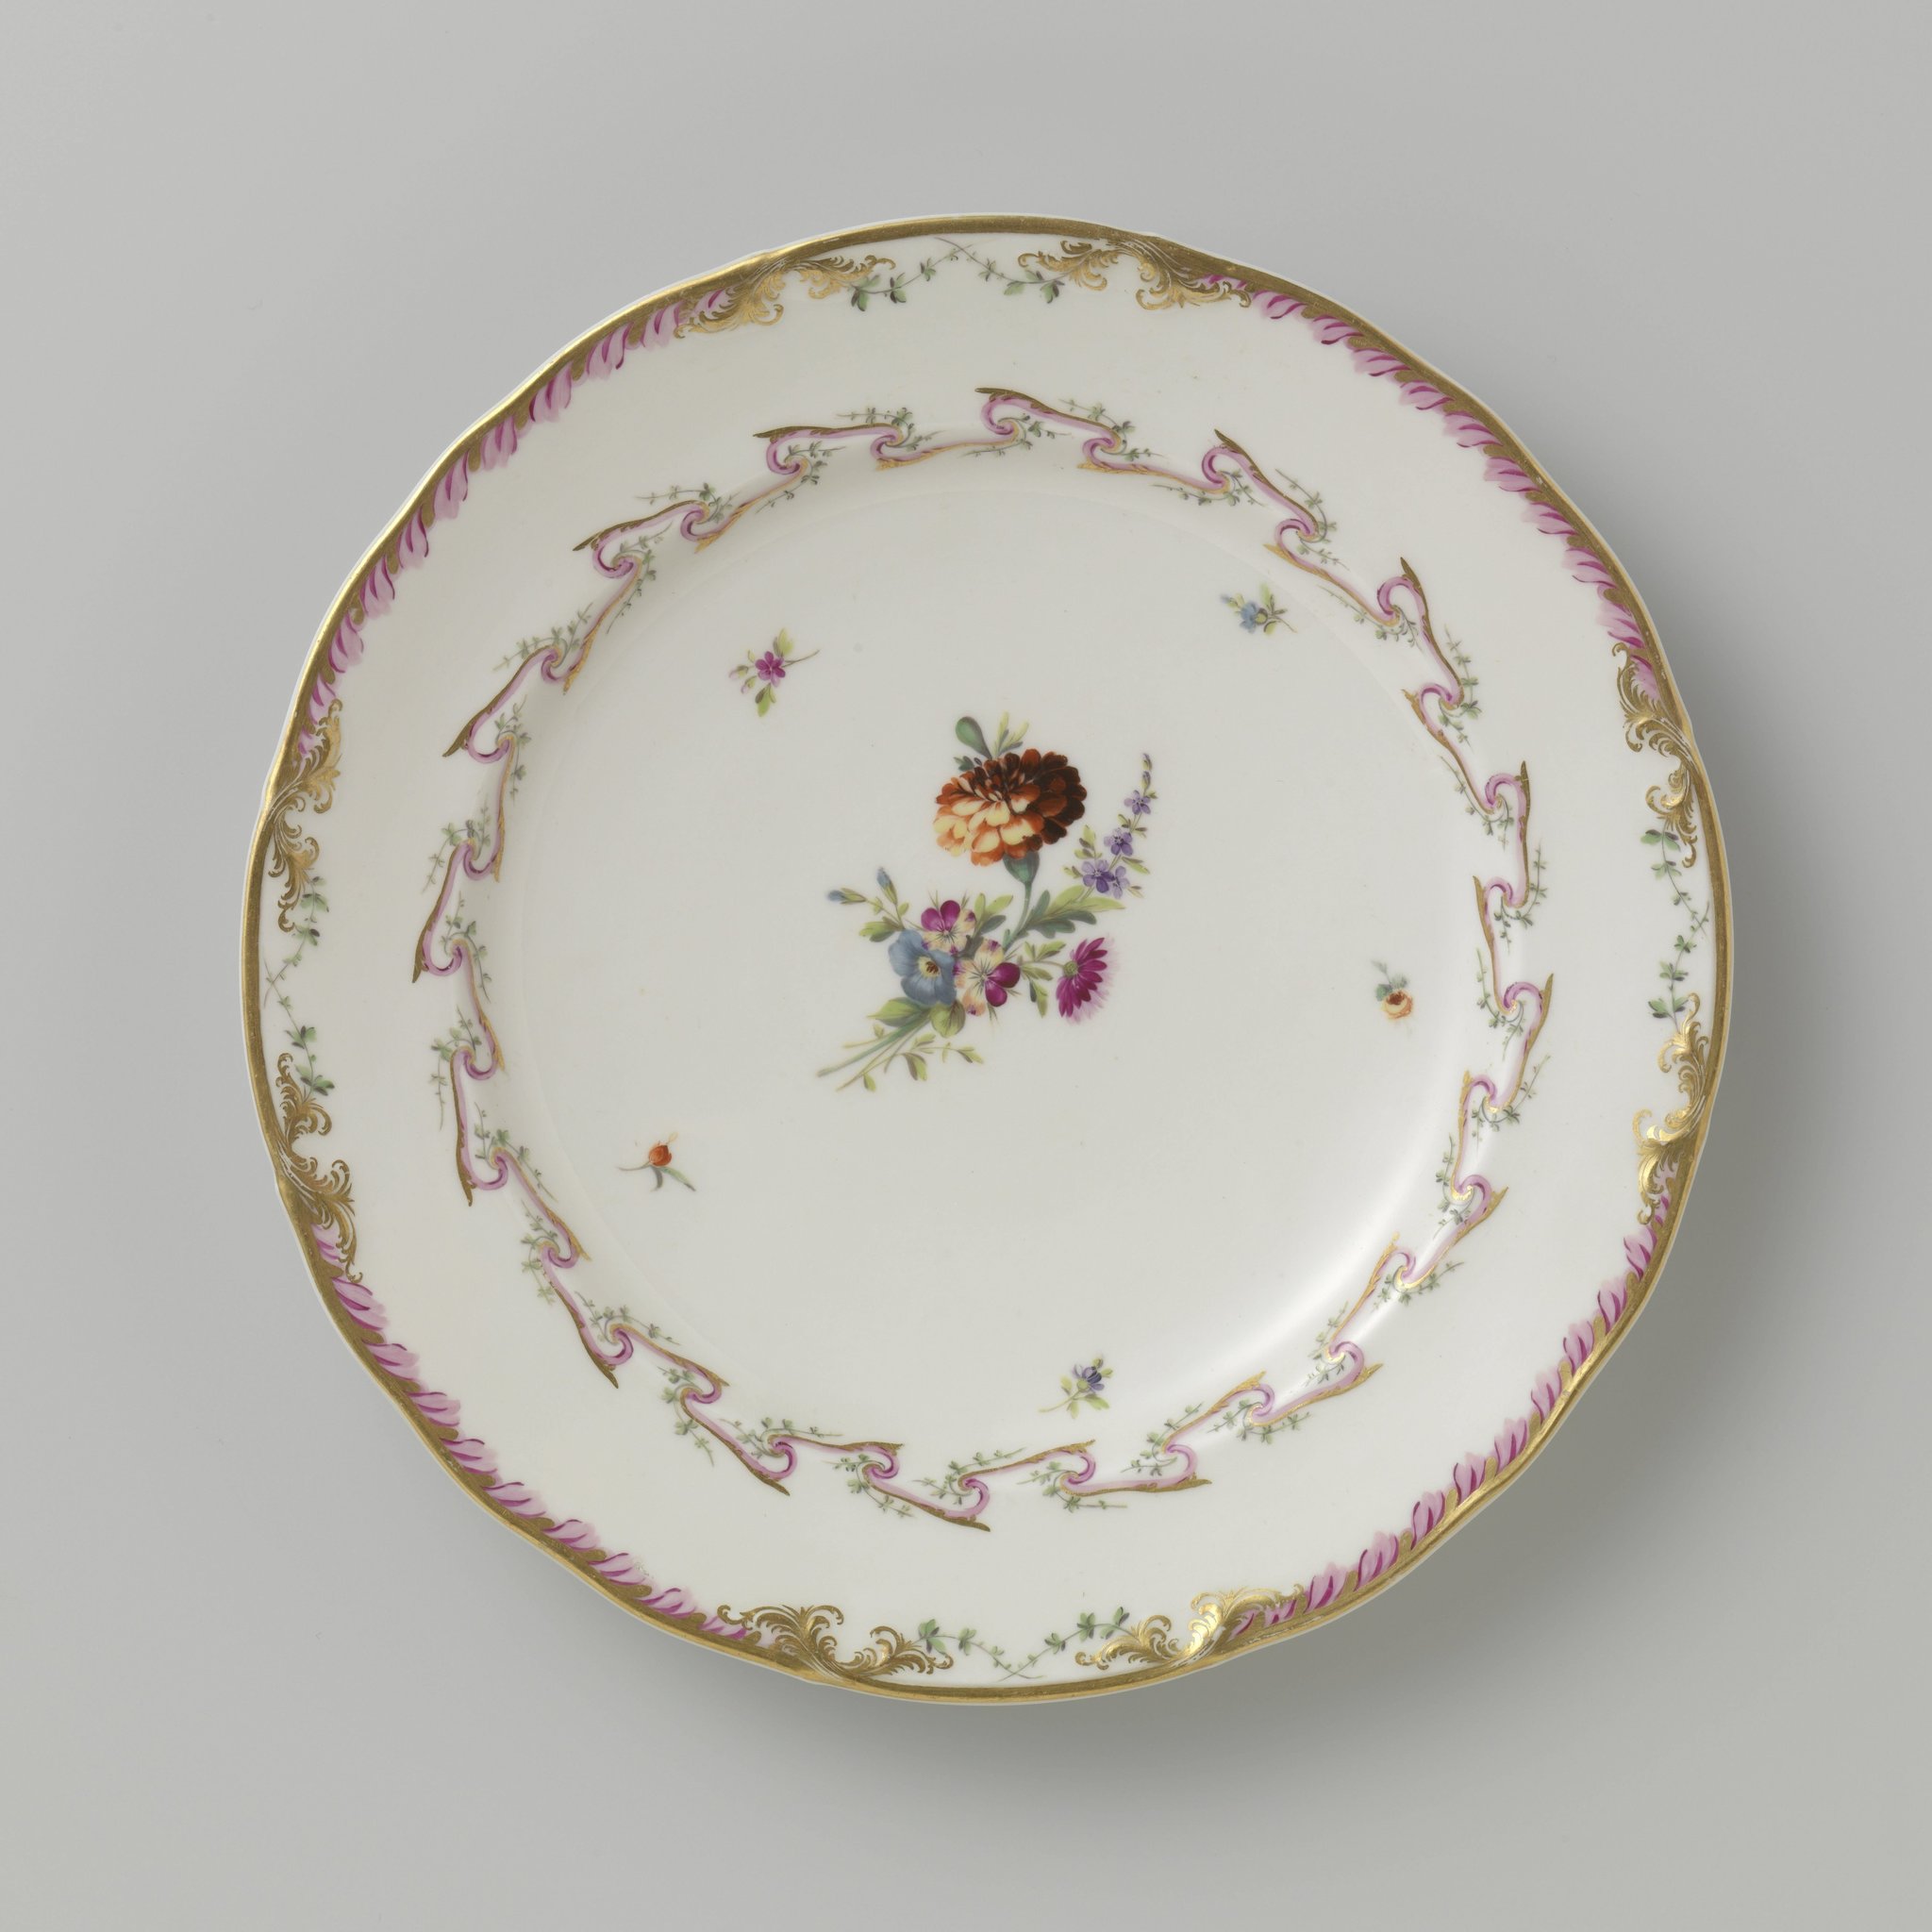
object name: plate dish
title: Bord, plat model, behorend bij een servies met geslingerd lintmotief met bladertakken, bloemboeketten en gestrooide bloemtakken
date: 1780-1820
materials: porcelain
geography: paris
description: Bord, plat model, behorend bij een servies van porselein met geslingerd lintmotief in paars en goud met groene bladertakken, bloemboeketten en gestrooide bloemtakken. Randen lichtgegolfd met decoratie in goud met paars bladmotief waartussen groen gekruist bladmotief. Gemerkt: Mf. DE DIHL ET GUERHARD à PARIS. Serie van elf stuks. Opmerking: modern.